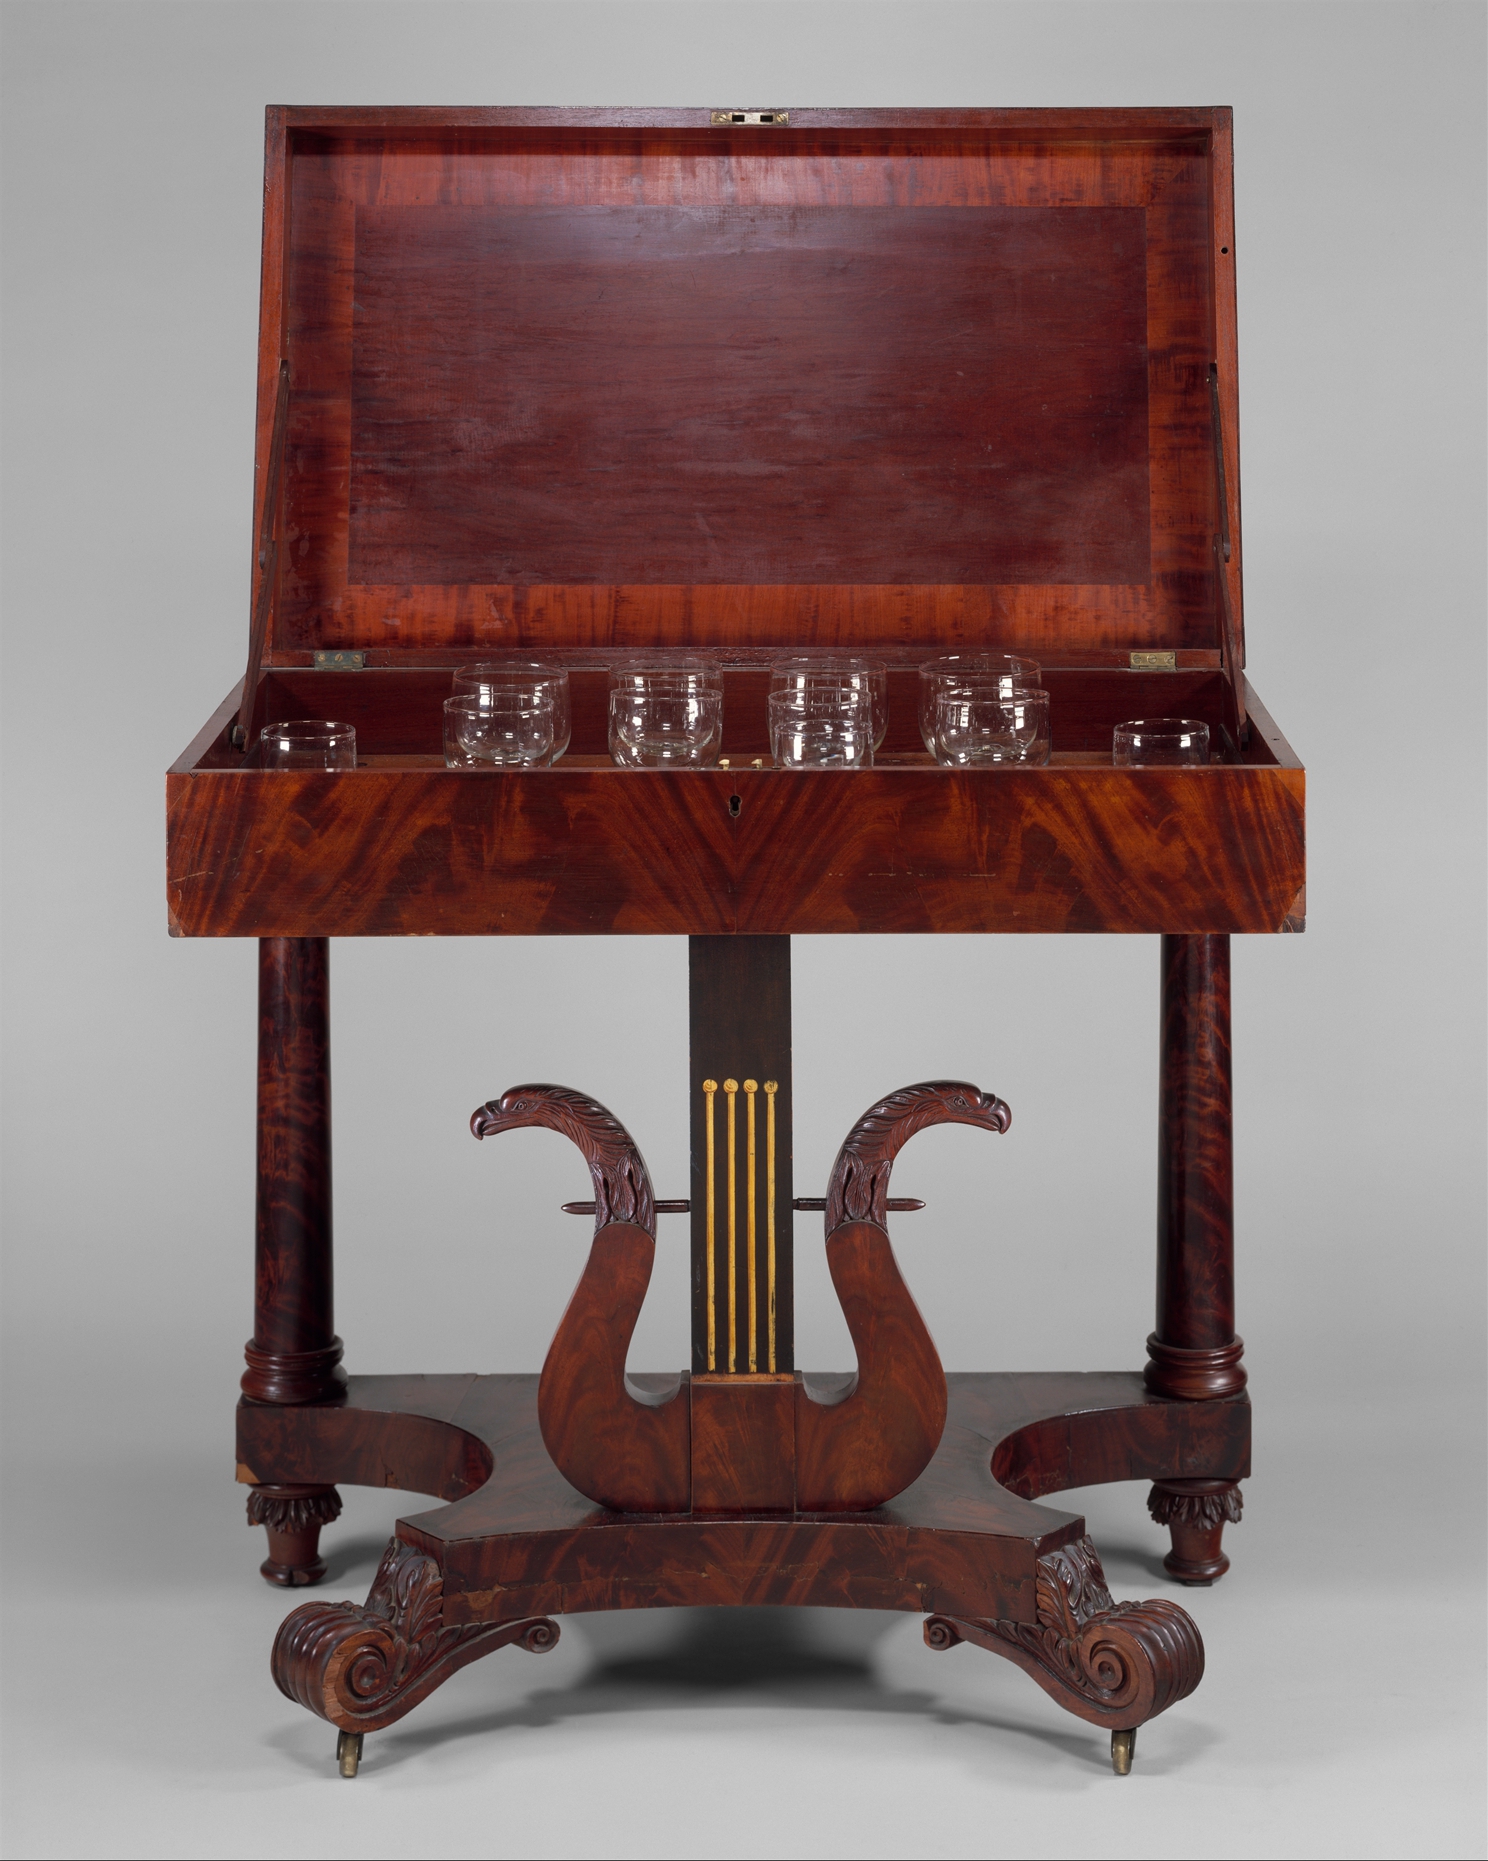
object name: grand harmonicon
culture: american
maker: francis hopkinson smith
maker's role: maker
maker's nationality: american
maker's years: 1838-1915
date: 1825-1830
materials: wood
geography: united states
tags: musical instruments